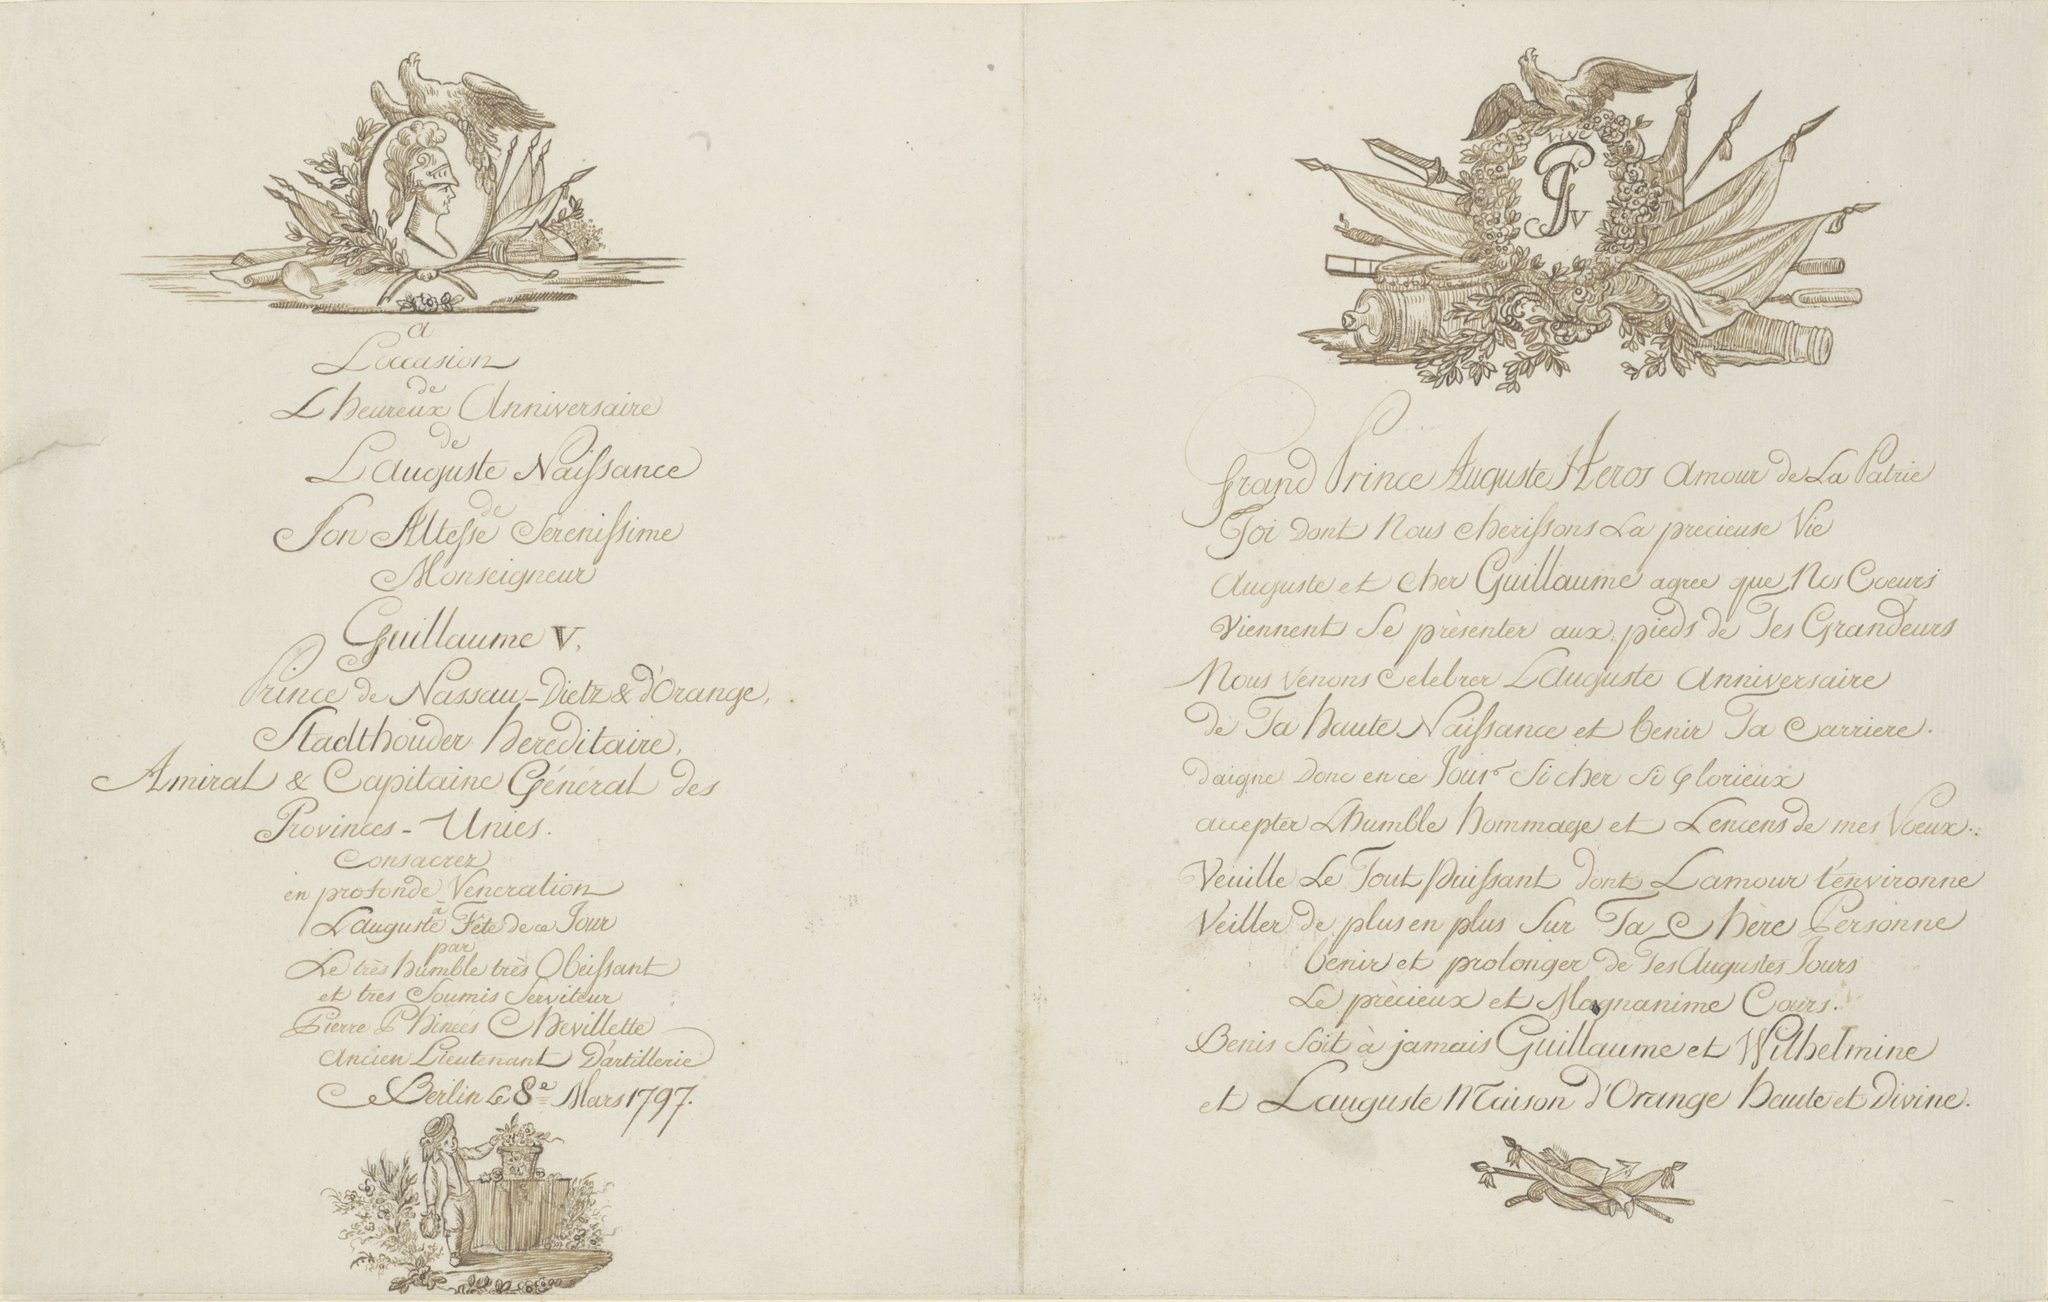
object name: drawing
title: Initialen van Willem V, prins van Oranje-Nassau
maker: Anonymous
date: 1797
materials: ink, paper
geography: low countries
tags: william v (prince of orange)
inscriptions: inscription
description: Rechts: Initialen van Willem V in een ovaal van bloemen met daar omheen een aantal allgorische objecten. Linksboven: Een portret in een ovaal met daar omheen een aantal allegorische objecten. Linksonder: Een jongen staat naast een pot met bloemen met in zijn rechterhand een lauwerkrans. Links en rechts een kolom met handgeschreven tekst.